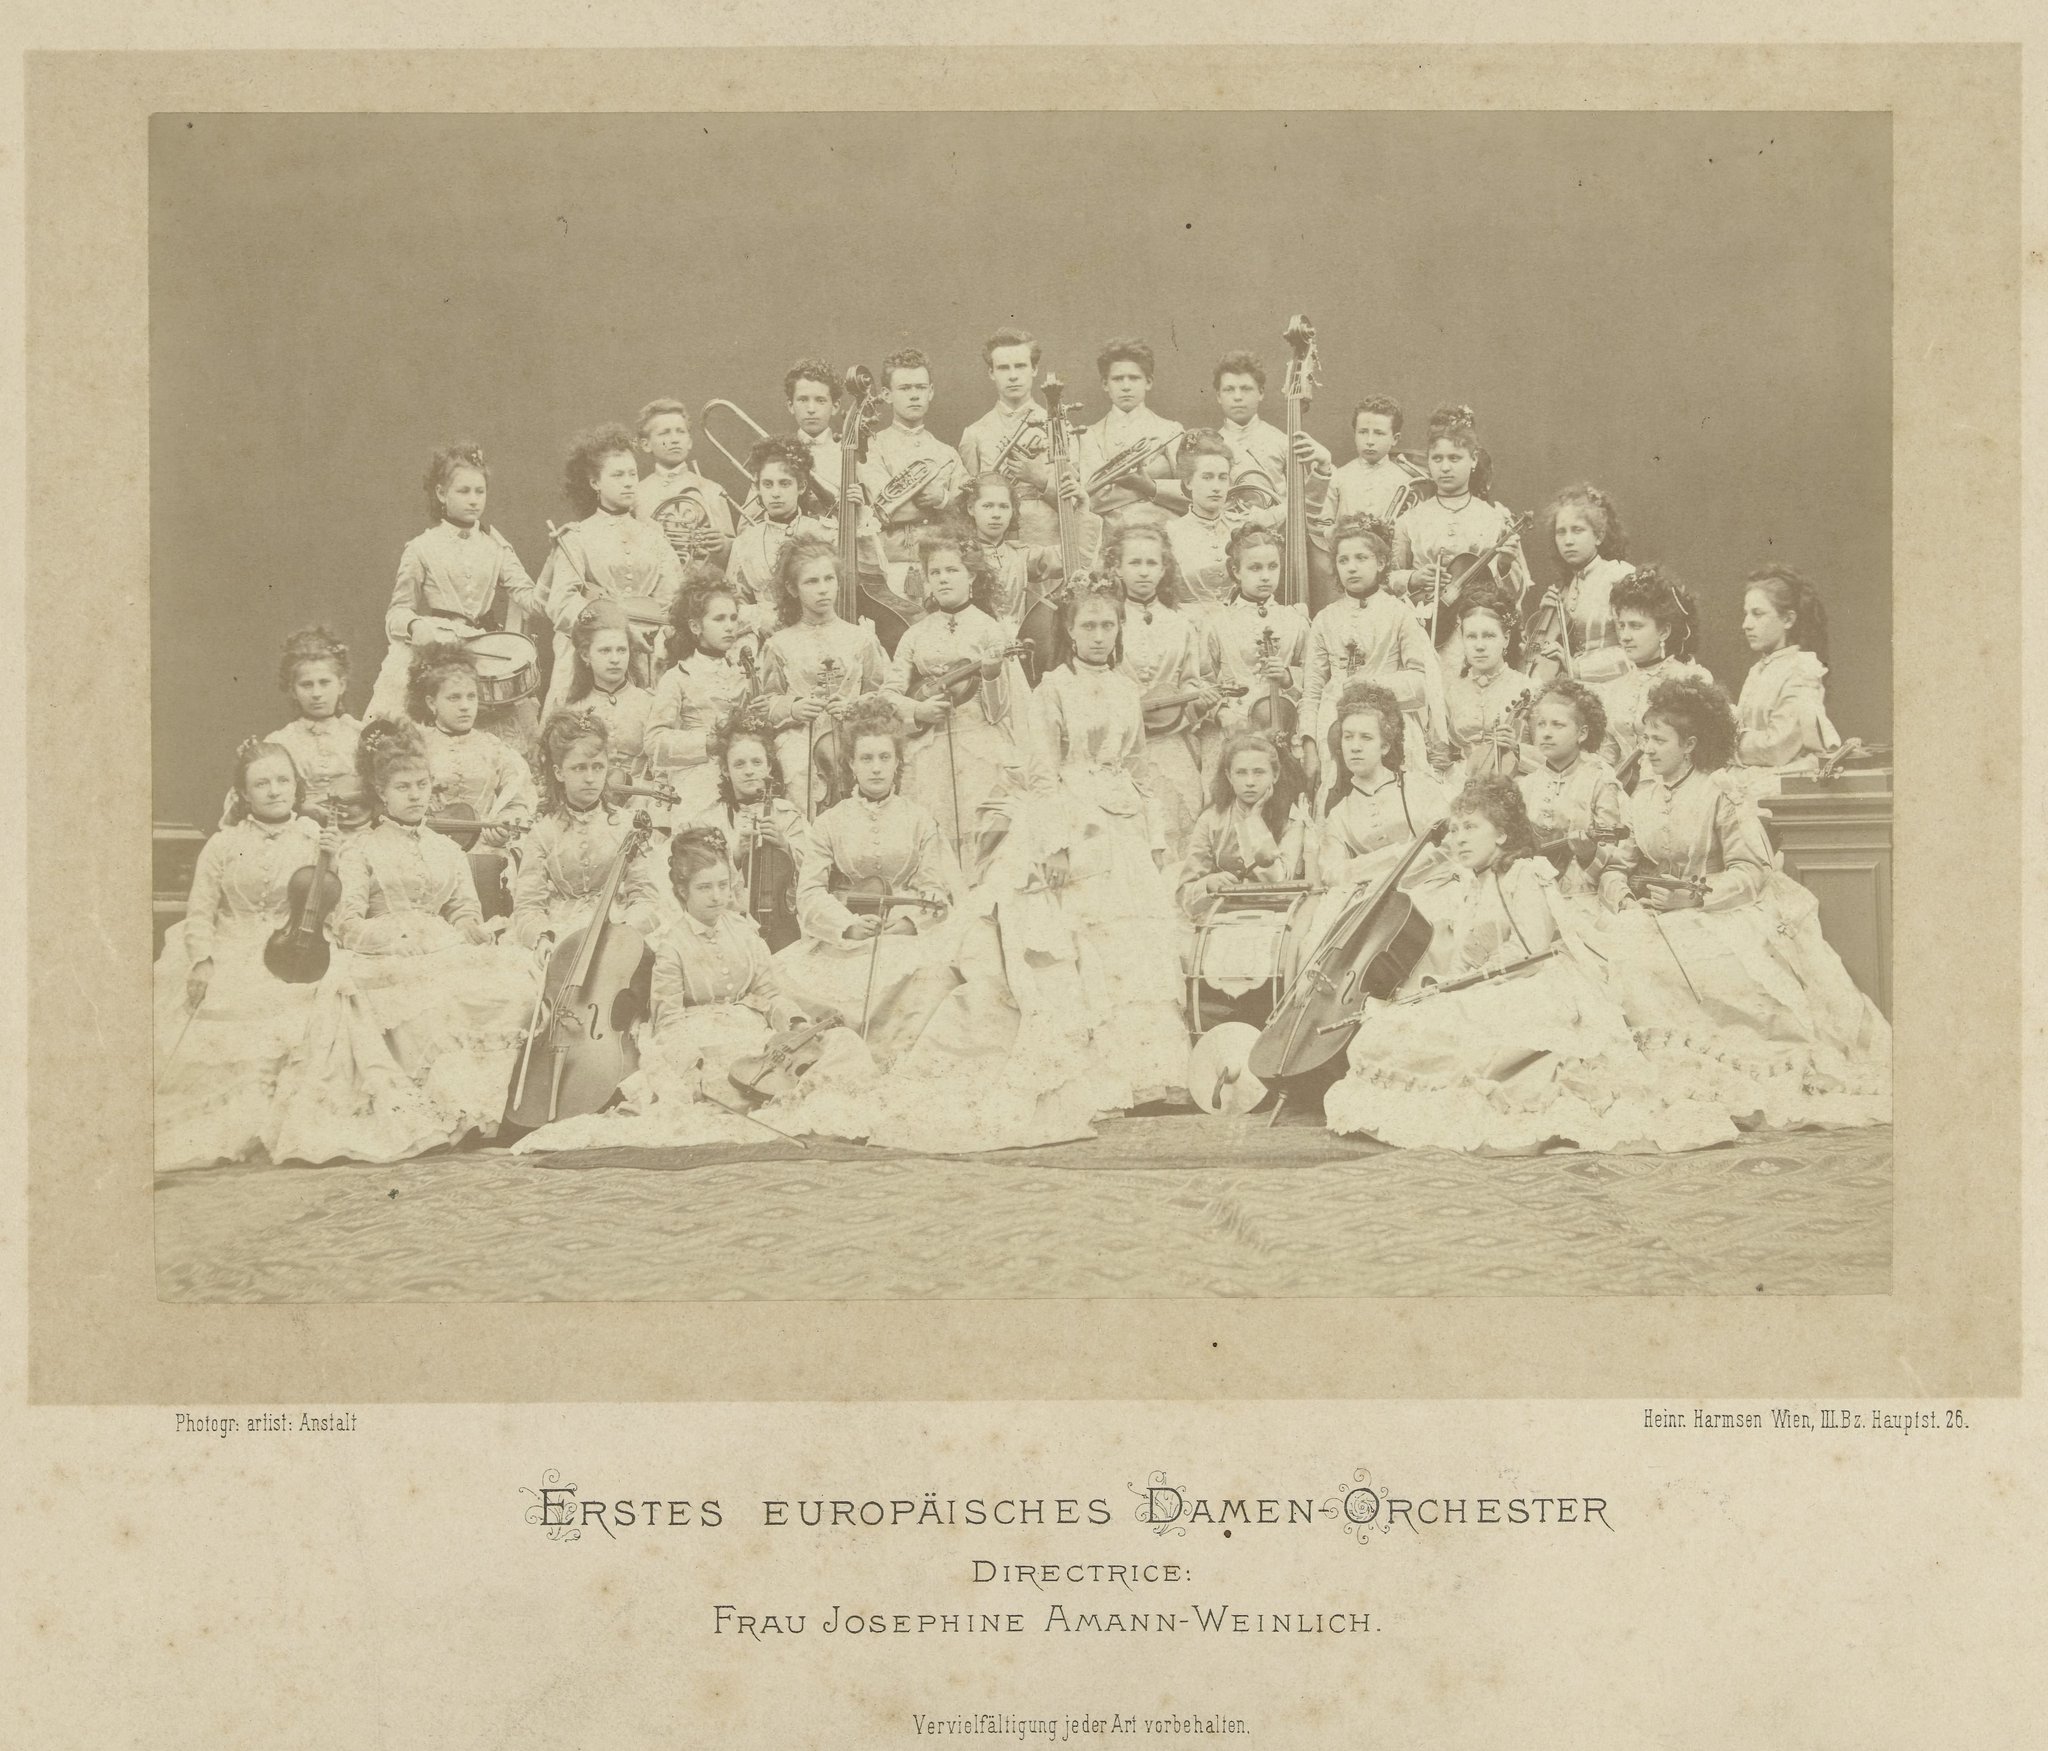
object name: photograph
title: Groepsportret van het eerste Europese vrouwenorkest onder leiding van Josefine Amann-Weinlich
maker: heinrich harmsen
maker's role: fotograaf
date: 1868-1887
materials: cardboard, paper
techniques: albumen print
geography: vienna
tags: vienna, musical instruments; group of musical instruments, anonymous historical persons portrayed in a group, in a group-portrait - bb - woman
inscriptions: inscription: ‘Vervielfältigung jeder Art vorbehalten.’, inscription: ‘Photogr: artist: Anstalt/ Heinr. Harmsen Wien, III Bz. Hauptst. 26.’, inscription: ‘DIRECTRICE:/ FRAU JOSEPHINE AMANN-WEINLICH.’